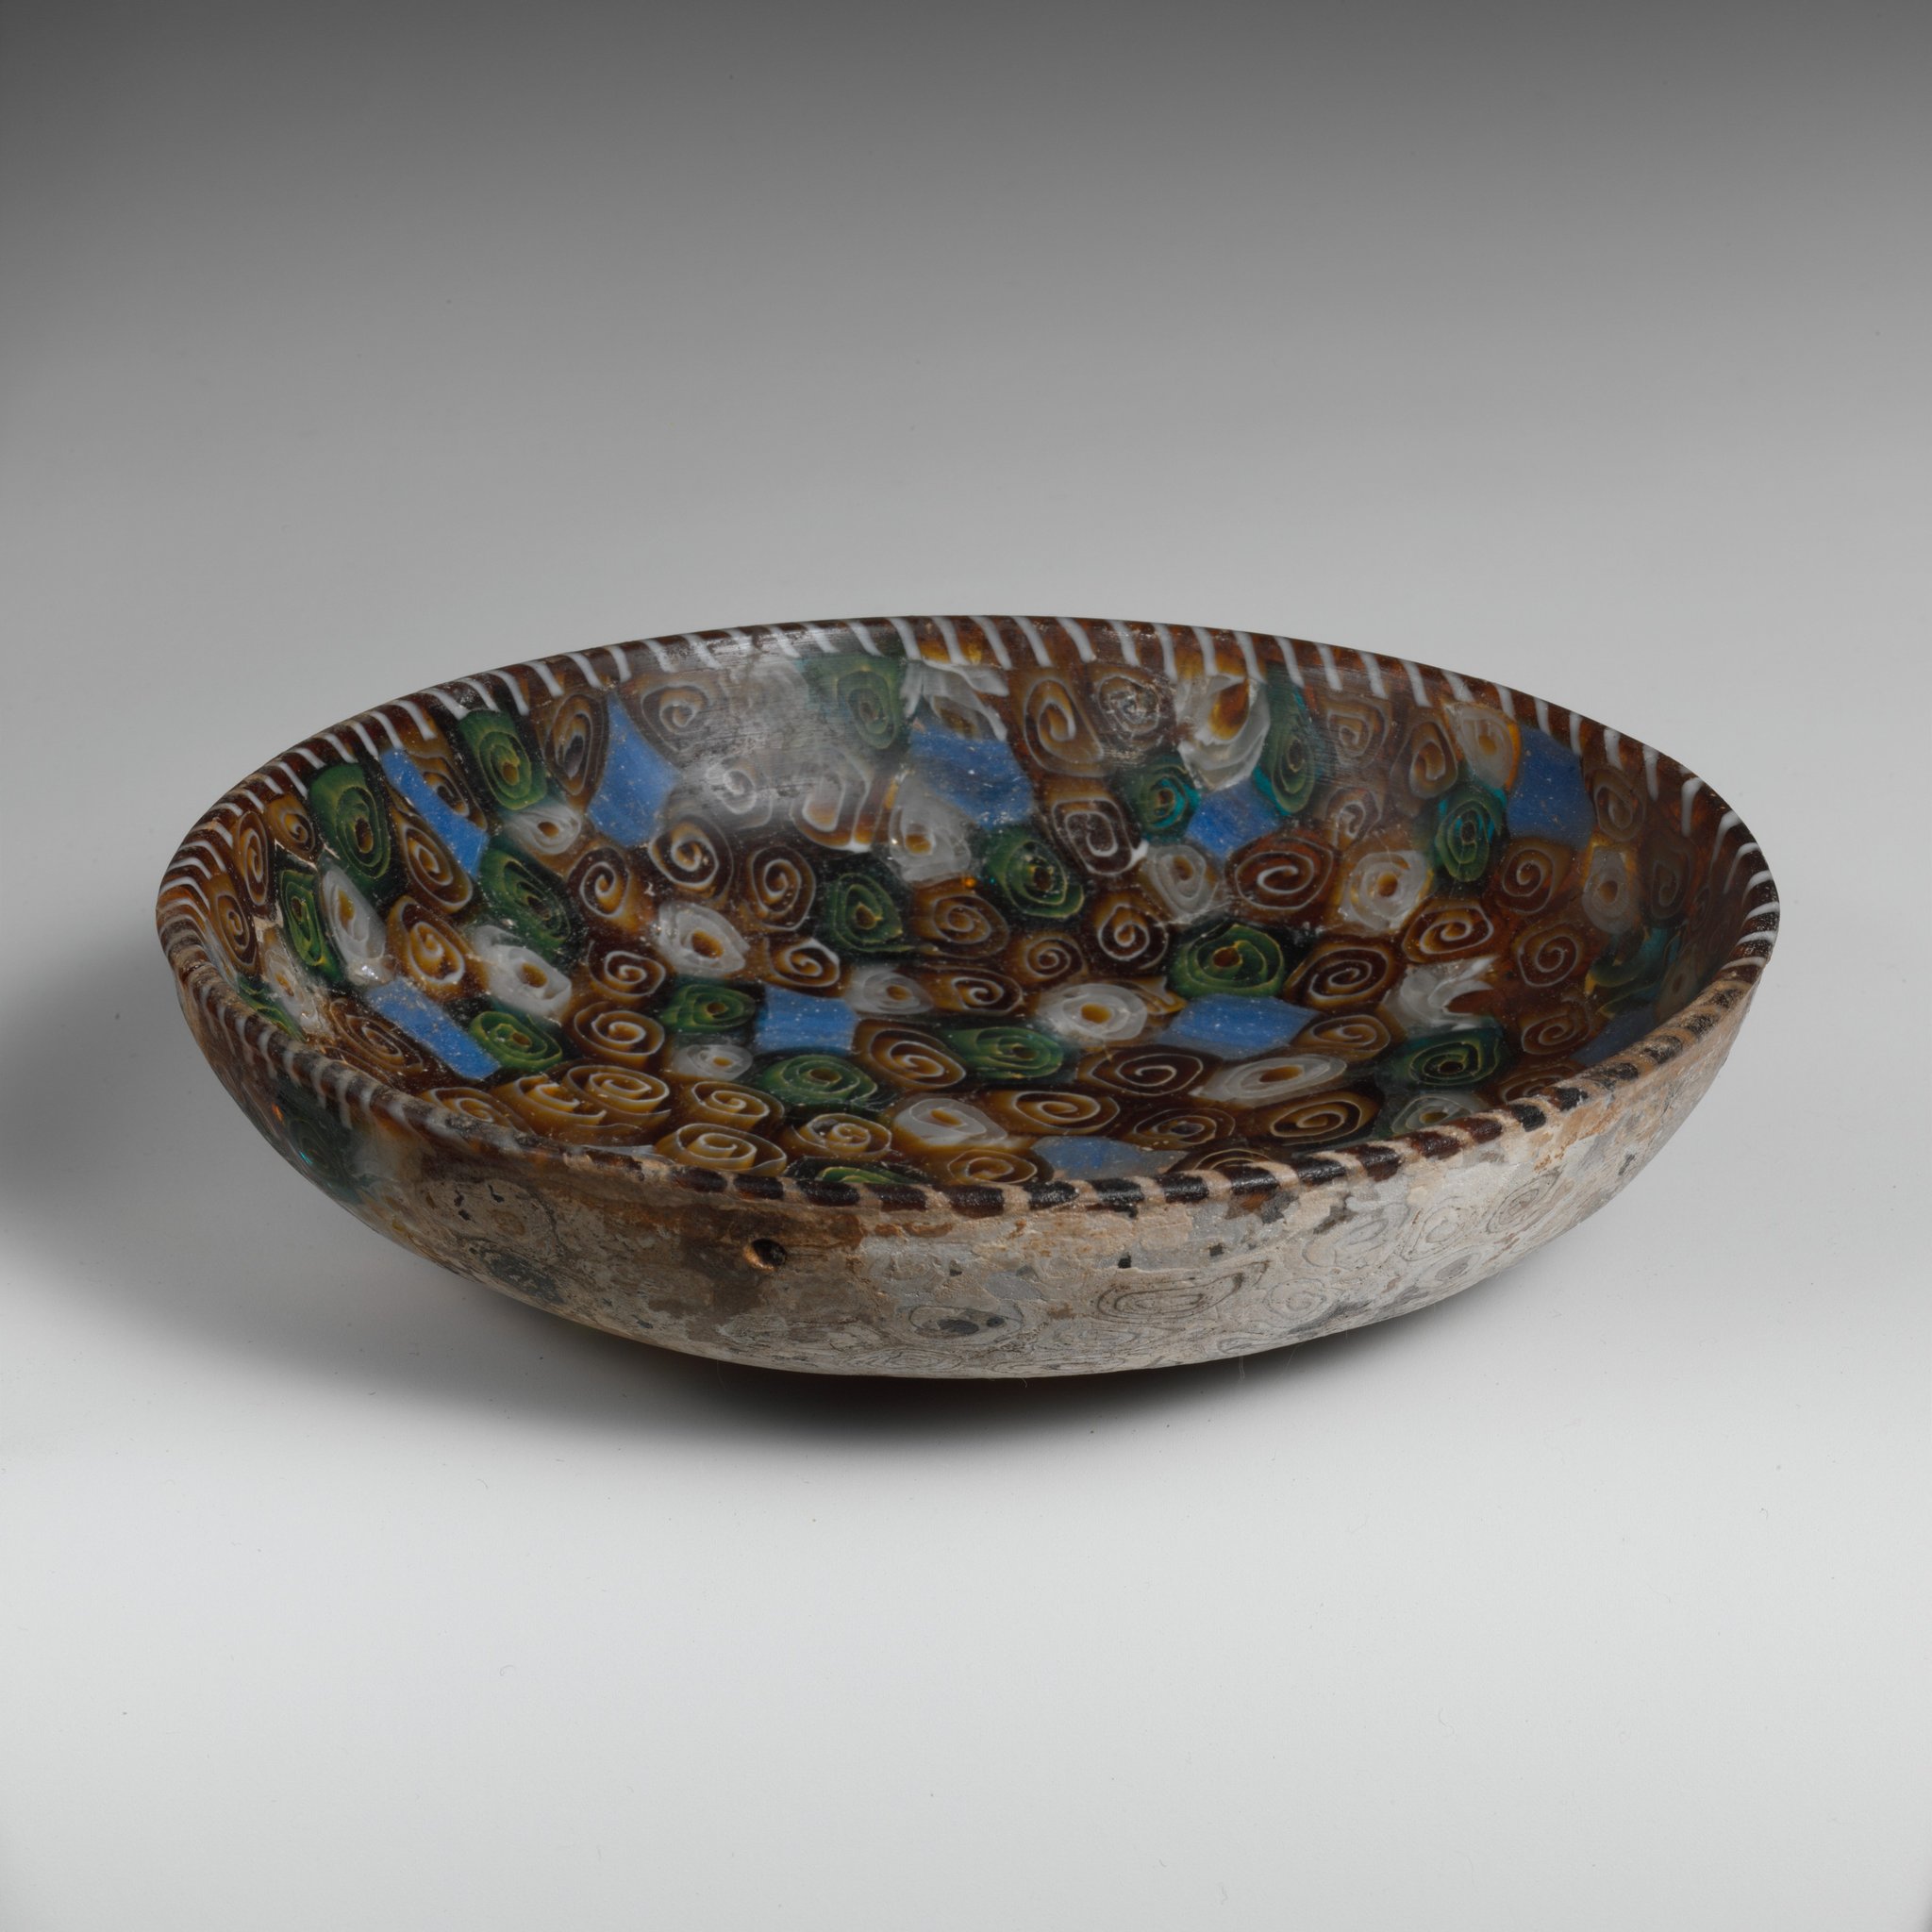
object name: bowl, mosaic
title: Glass mosaic bowl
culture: greek, eastern mediterranean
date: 200-35 BCE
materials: glass